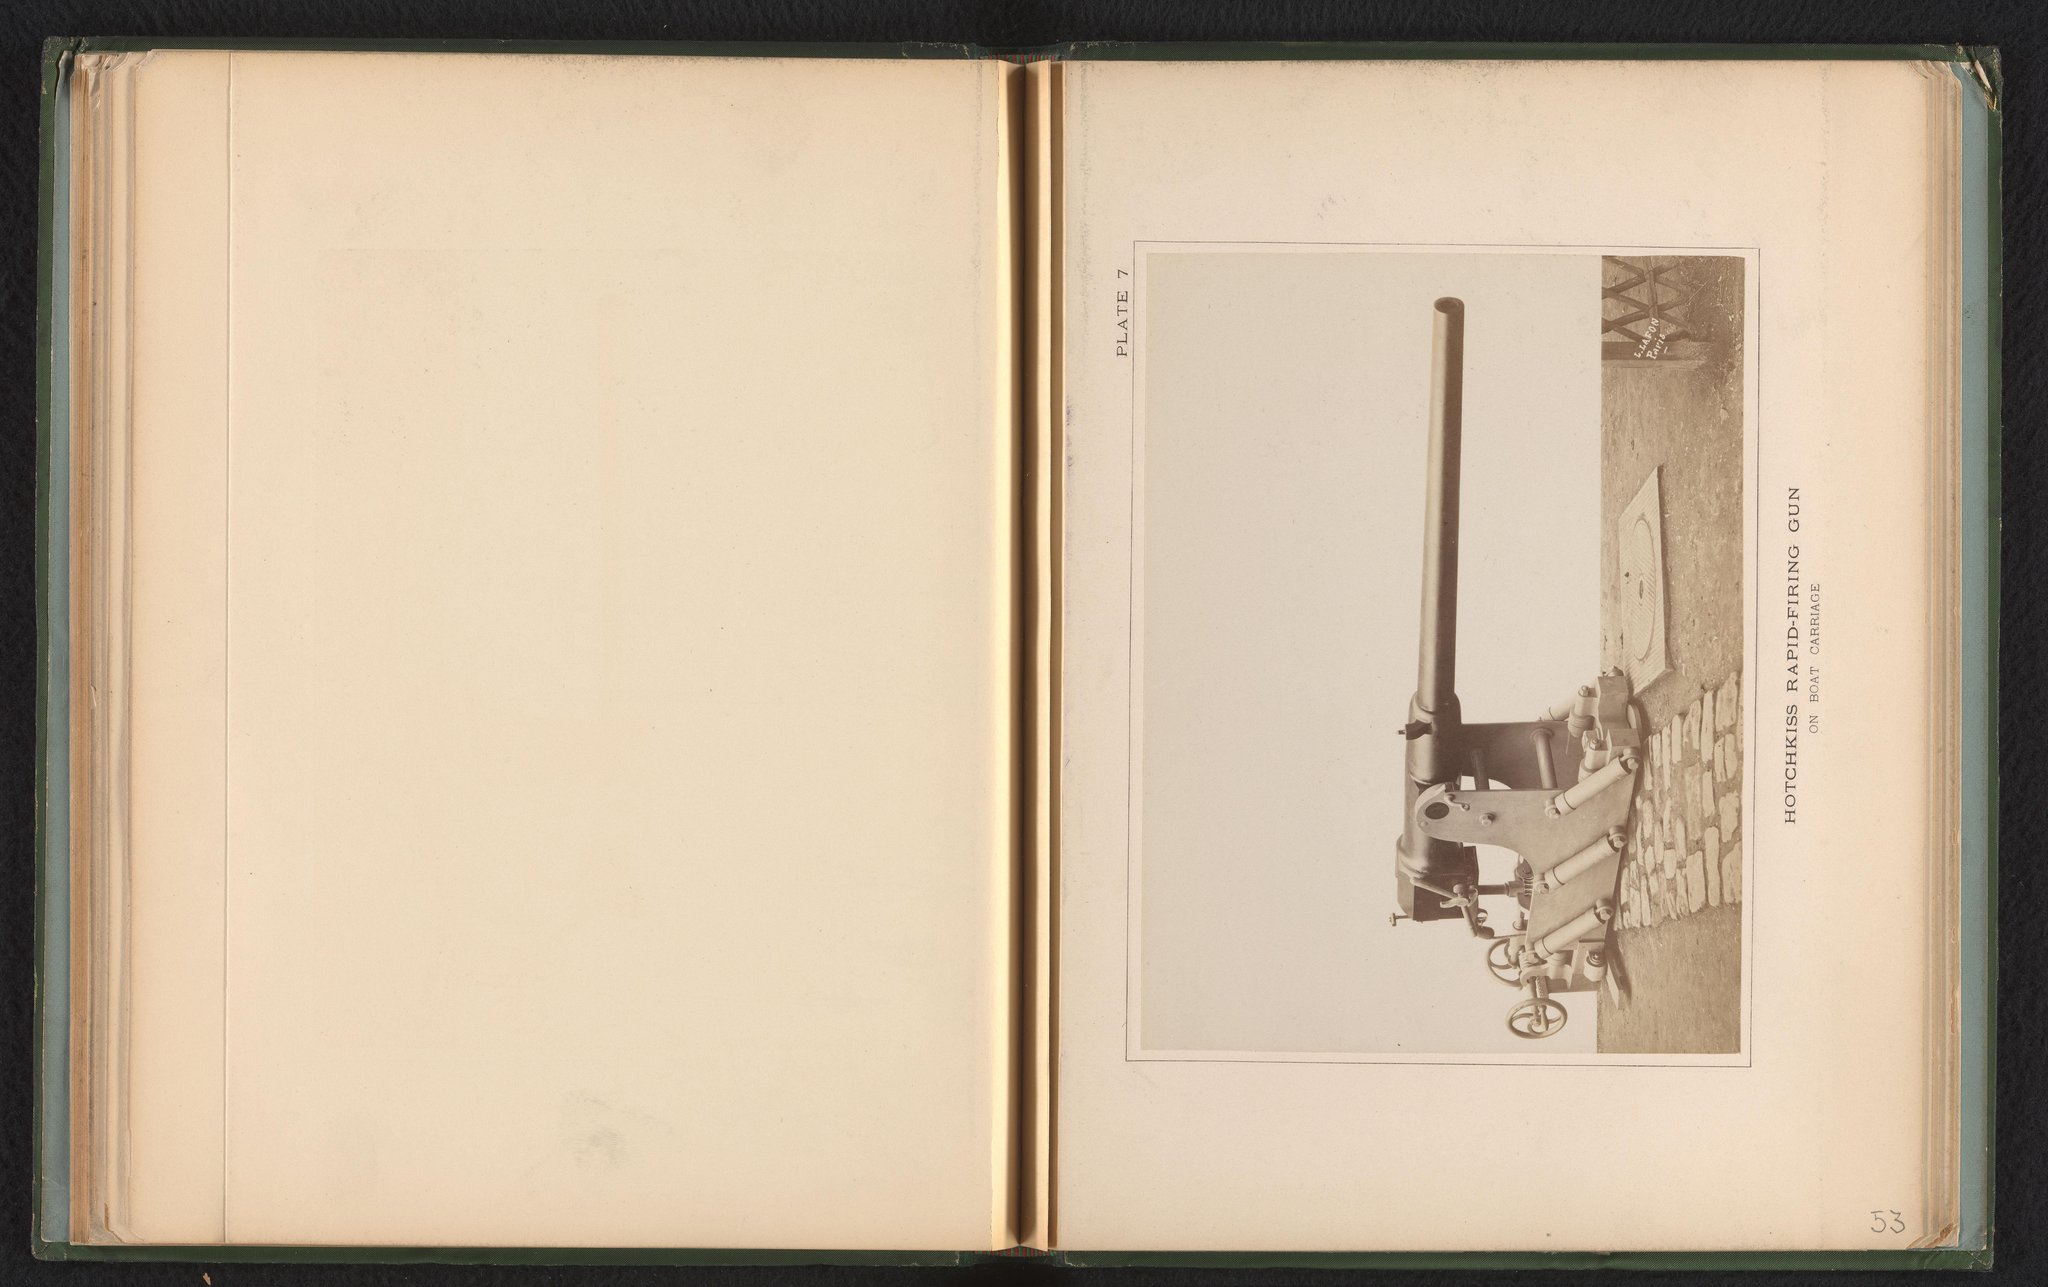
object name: page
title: Hotchkiss snelvuurkanon op een wagen voor een boot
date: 1879-1884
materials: cardboard, photographic support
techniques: albumen print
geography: paris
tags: firearms: cannon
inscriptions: inscription: ‘PLATE 7/HOTCHKISS RAPID-FIRING GUN/ ON BOAT CARRIAGE’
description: Foto op veertiende ongenummerde pagina na pagina 39.